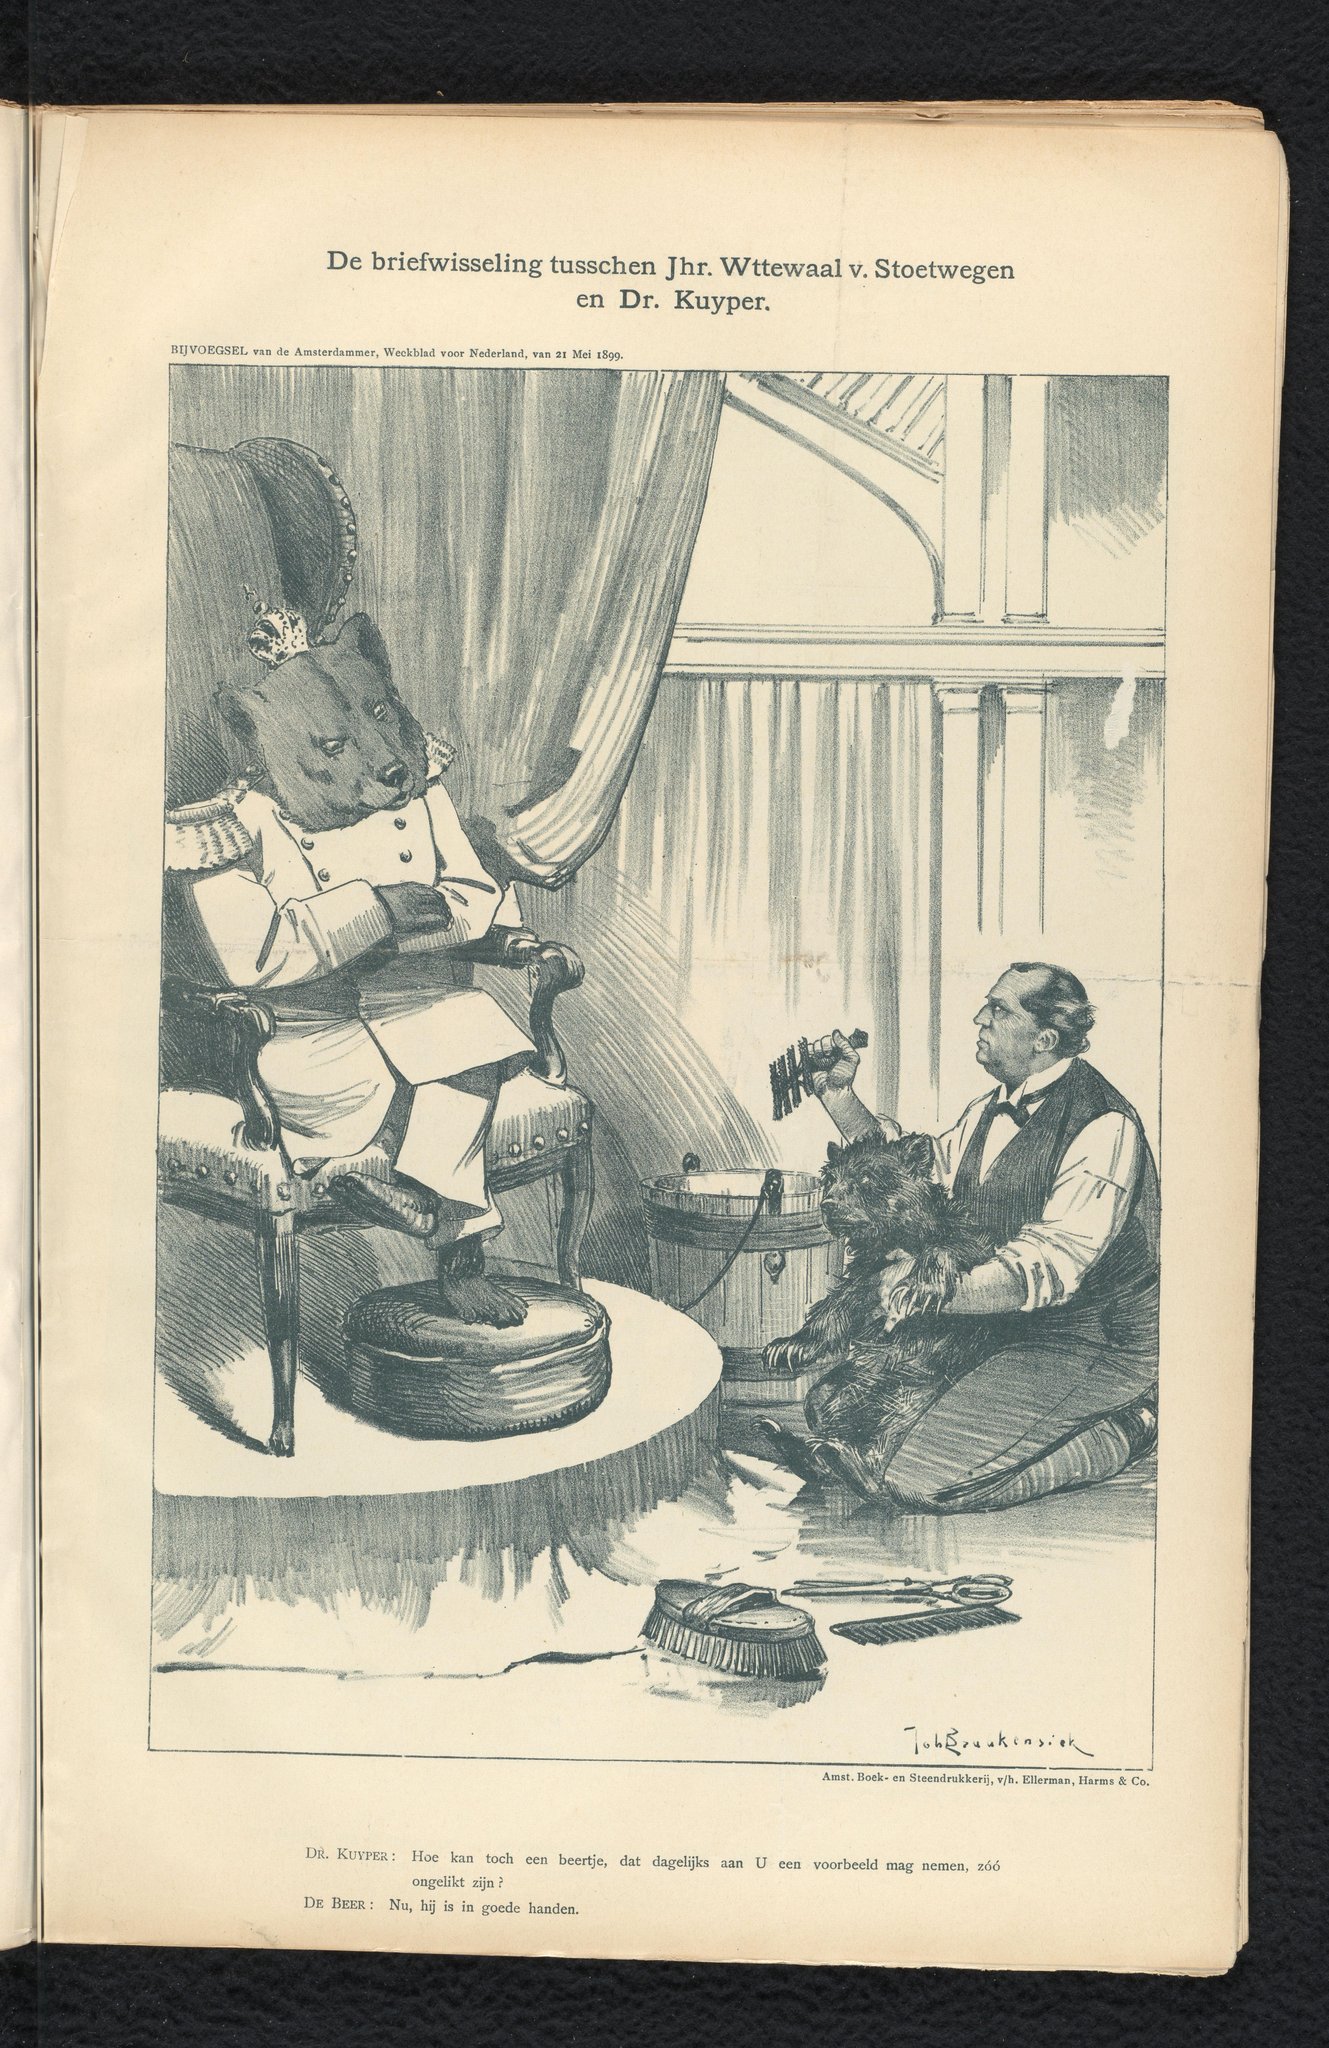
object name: cartoon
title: De briefwisseling tusschen Jhr. Wttewaal v. Stoetwegen en Dr. Kuyper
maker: johan braakensiek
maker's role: draughtsman, print maker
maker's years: 1858-1940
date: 1899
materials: paper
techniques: lithograph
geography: netherlands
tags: the hague, abraham kuyper, personifications of countries, nations, states, districts, etc., beasts of prey, predatory animals: bear, political caricatures and satires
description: Abraham Kuyper wast een 'ongelikt beertje' (Wttewaall van Stoetwegen, Nederlands diplomaat in Rusland) in een tobbe. Een volwassen Russische beer (tsaar Nicolaas II) kijkt gezeten op zijn troon toe.